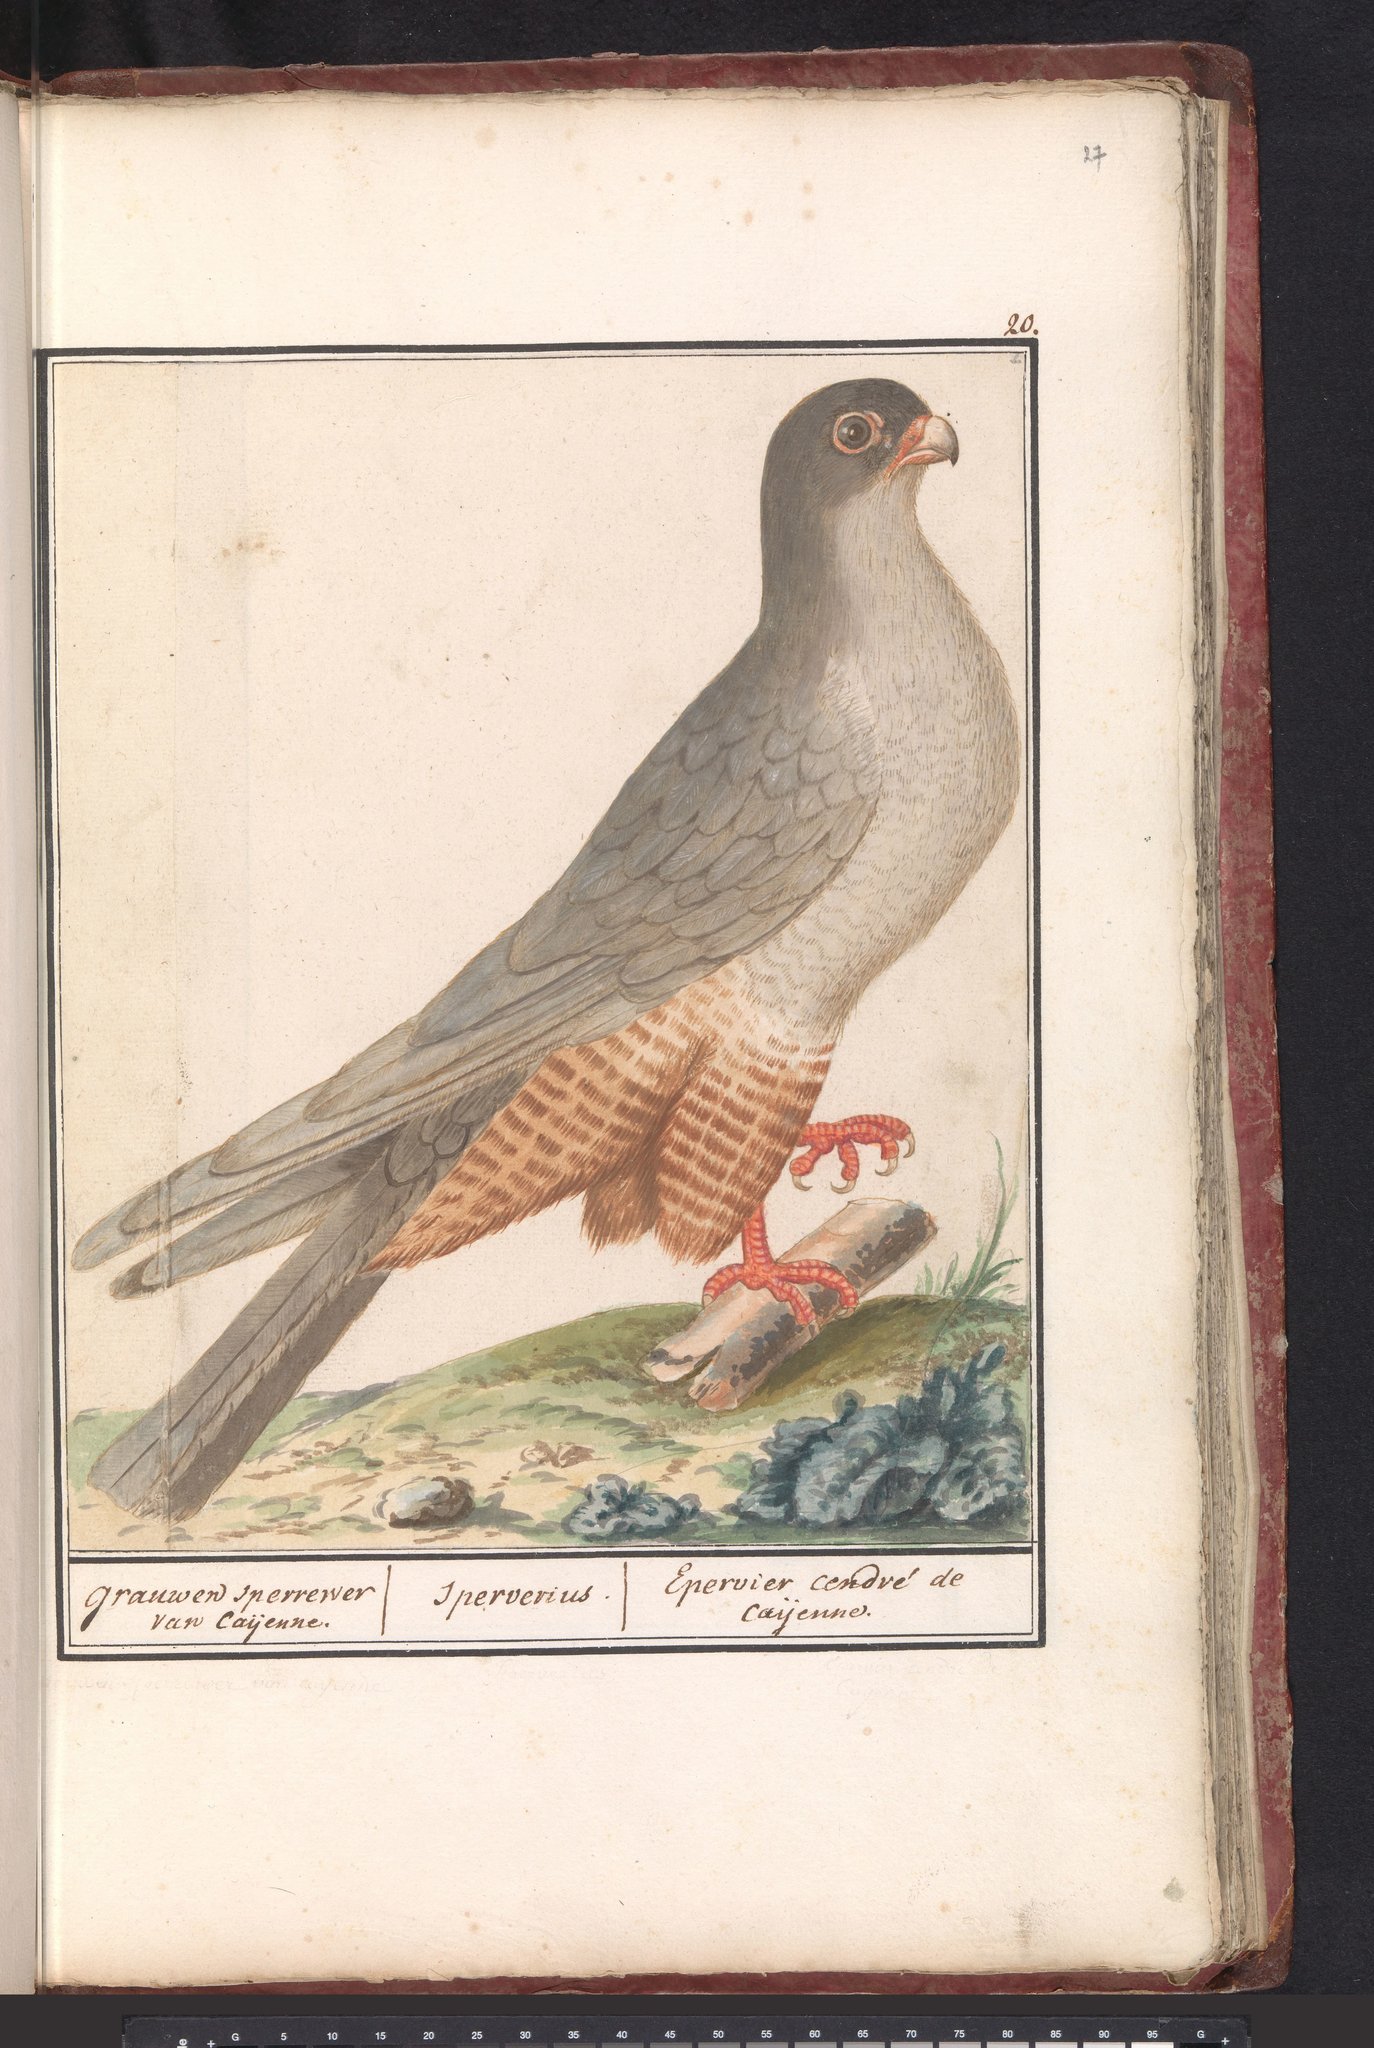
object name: drawing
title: Red-footed Falcon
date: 1596-1610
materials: paint, paper, pencil, watercolor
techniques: brush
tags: predatory birds: red-footed falcon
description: Roodpootvalk. Genummerd rechtsboven: 20. Onderdeel van het eerste album met tekeningen van vogels. Derde van twaalf albums met tekeningen van dieren, vogels en planten bekend rond 1600, gemaakt in opdracht van keizer Rudolf II. Met toelichting in Nederlands, Latijn en Frans.